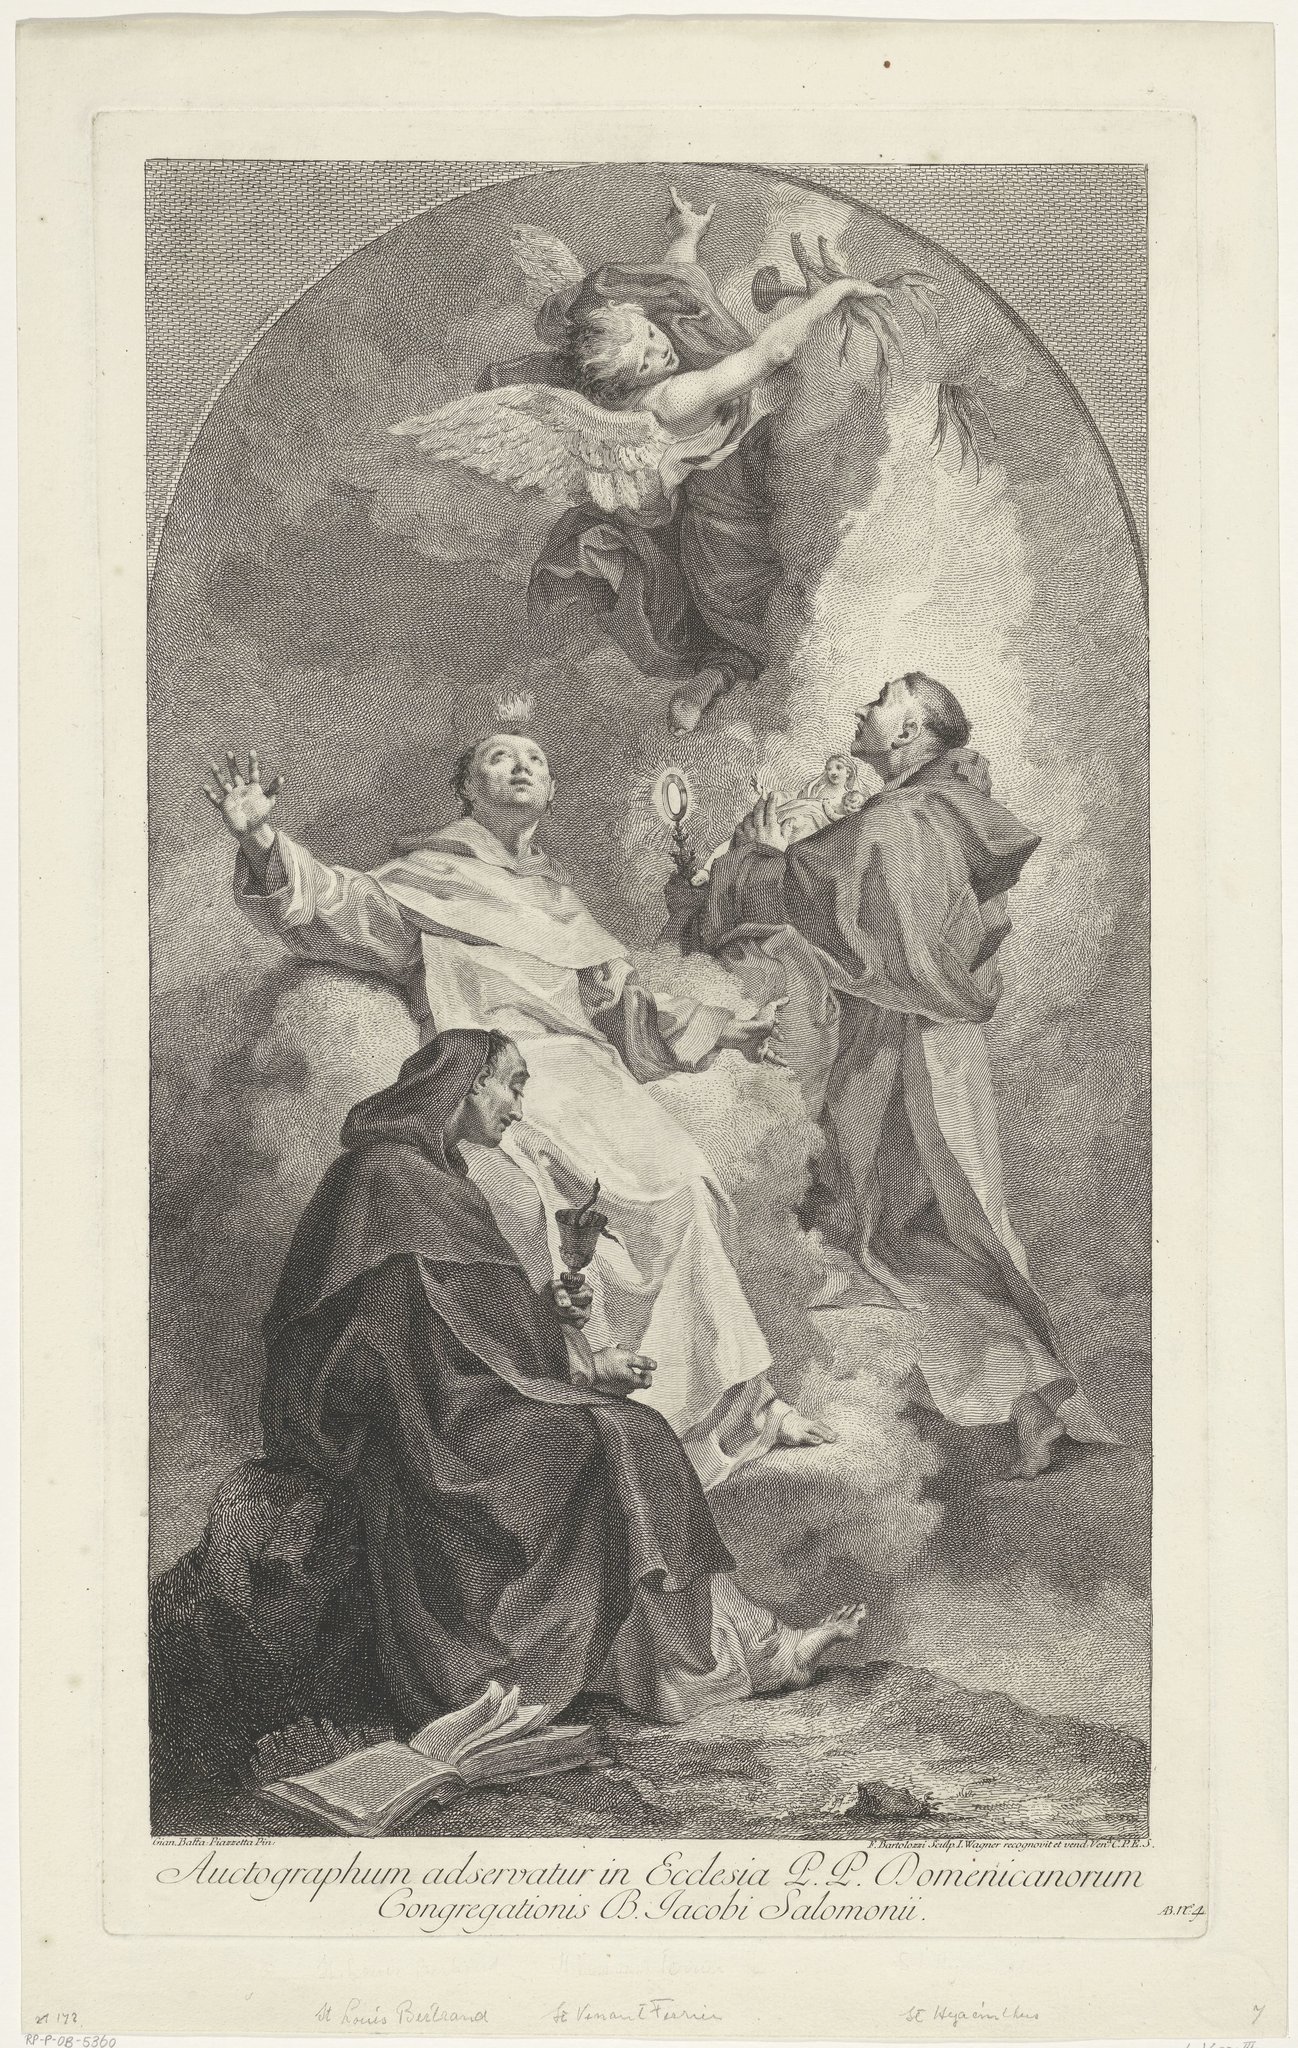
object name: print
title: Drie Dominicaanse heiligen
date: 1739-1780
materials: paper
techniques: engraving, etching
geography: italy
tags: saints, angels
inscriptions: collector's mark: Lugt 240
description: De heilige Lodewijk Beltrán met kelk en boek, de heilige Vincent Ferrier met een vlam boven zijn hoofd en de heilige Hyacinthus van Polen met een beeld van Maria met Kind. Boven zweeft een engel.